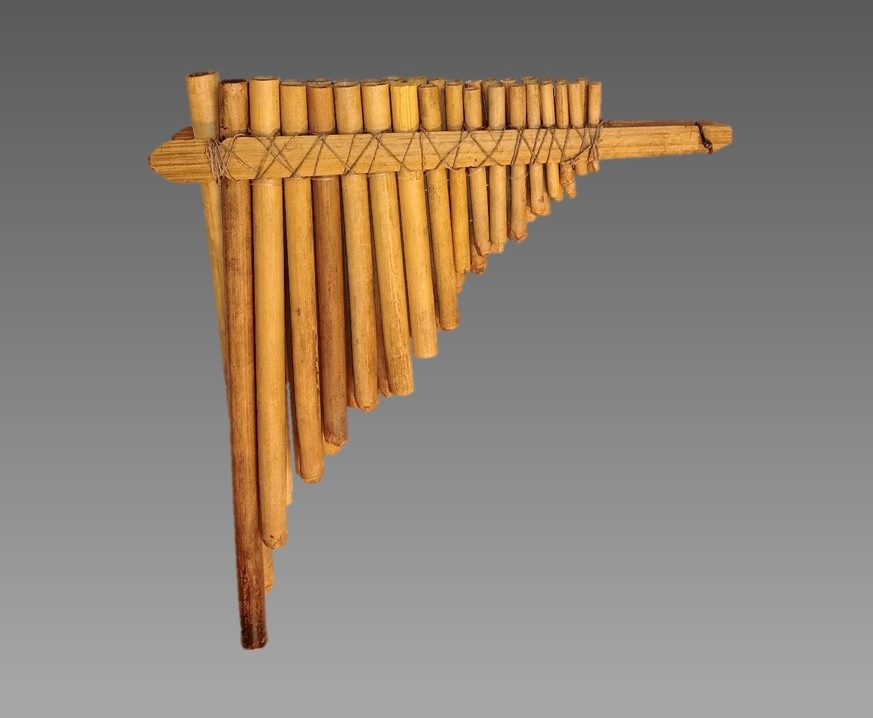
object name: galeon soniruka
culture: melanesian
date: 1867-1900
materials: bamboo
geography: solomon islands